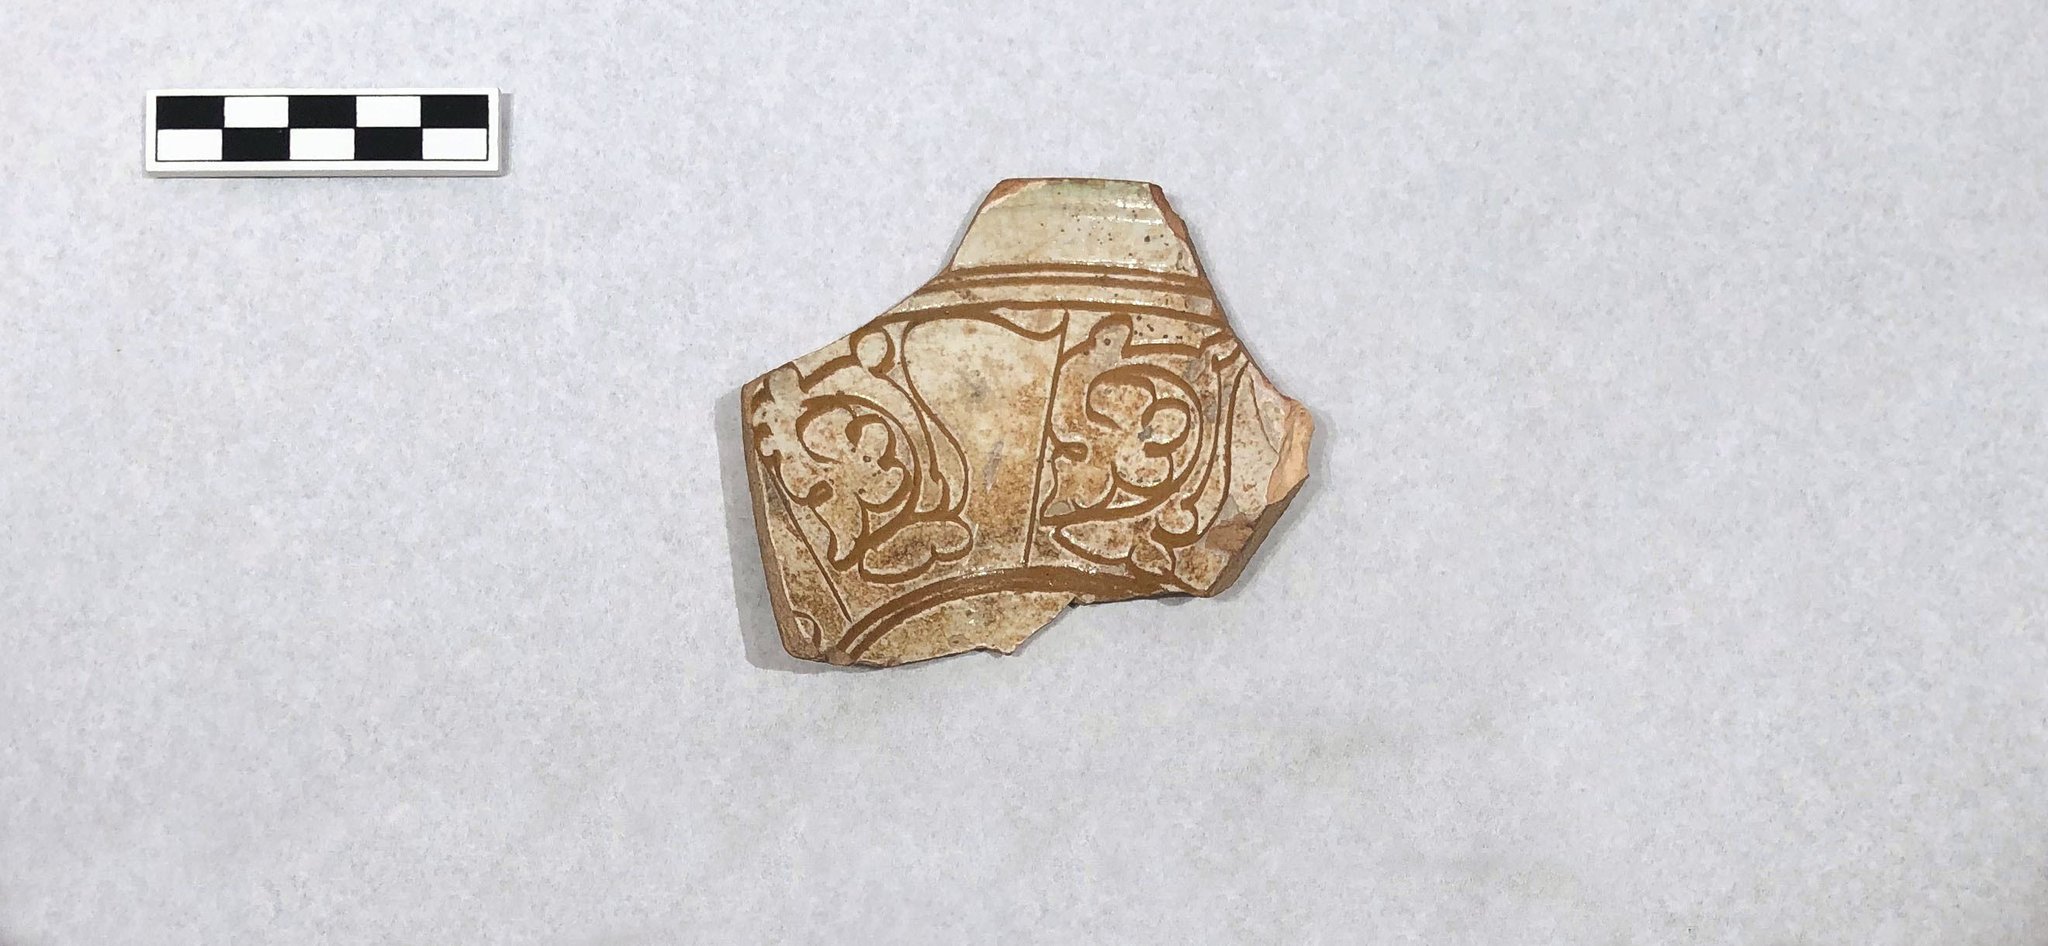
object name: fragment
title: Ceramic Fragment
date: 801-1000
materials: earthenware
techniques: glazing, incising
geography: iran